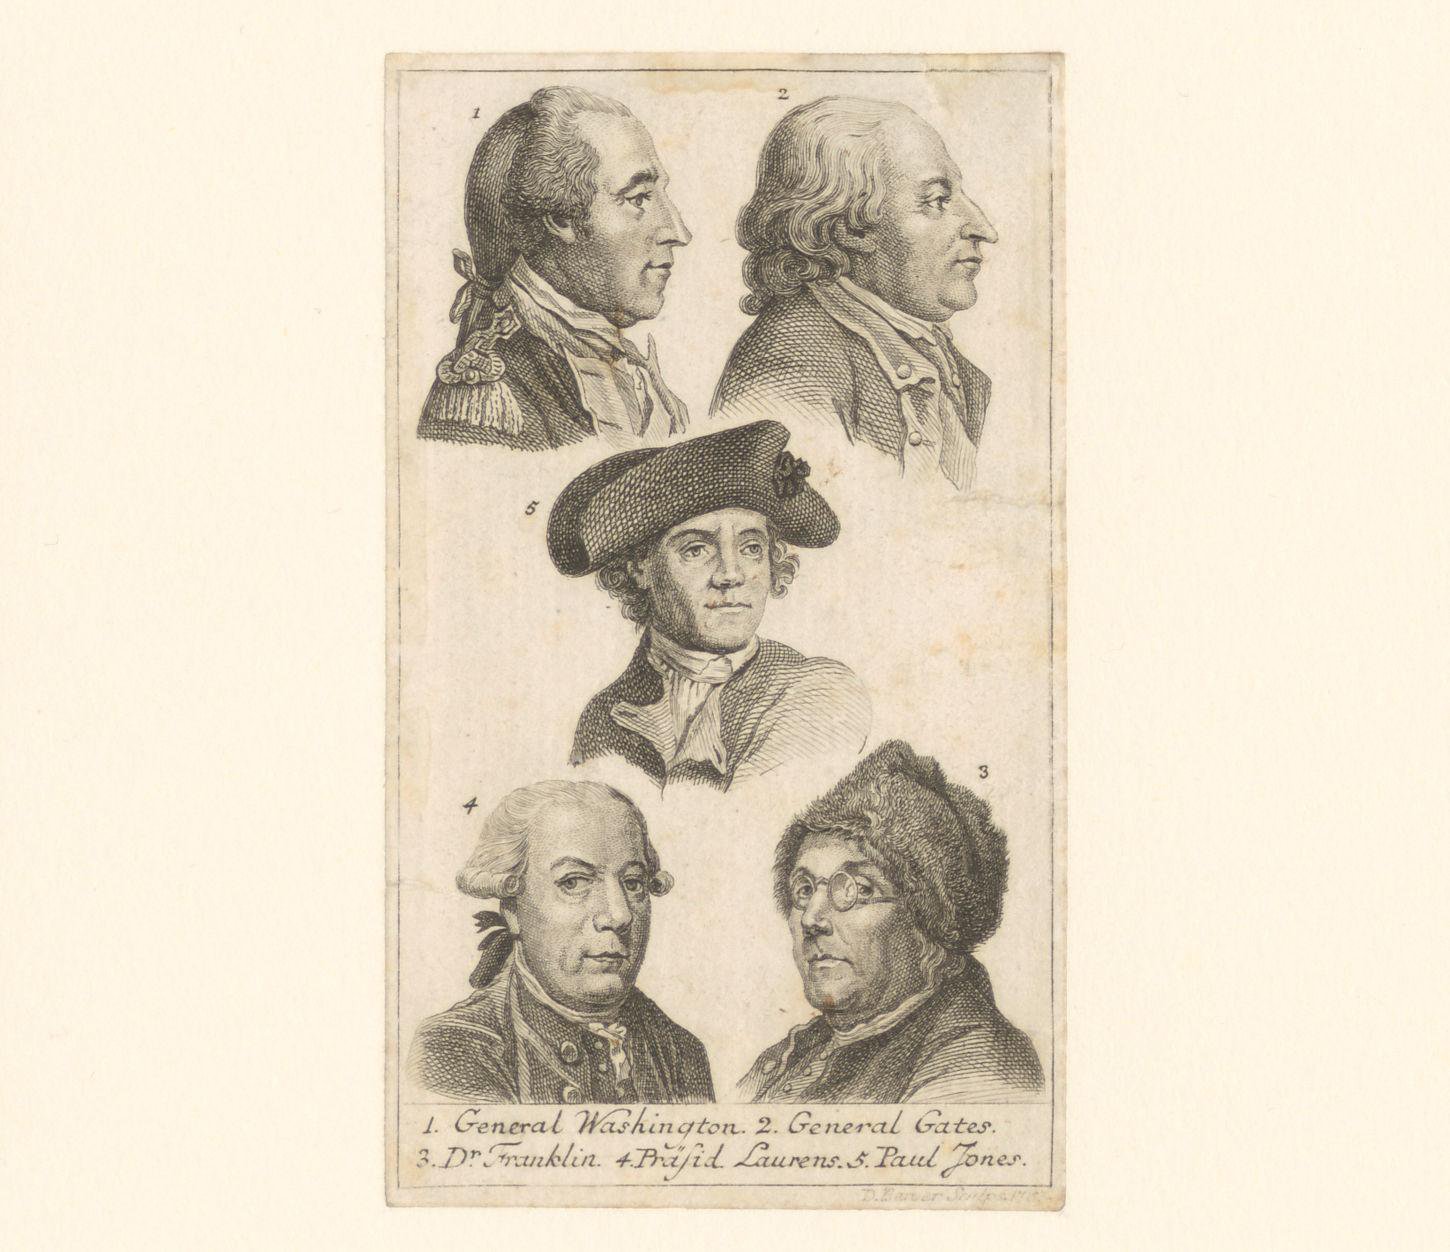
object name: book illustration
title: Portretten van George Washington, Horatio Gates, Benjamin Franklin, Henry Laurens en John Paul Jones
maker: daniel berger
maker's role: print maker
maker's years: 1744-1824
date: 1783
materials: paper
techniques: etching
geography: berlin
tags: capuche, new york (city), historical persons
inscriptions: collector's mark: Lugt 2228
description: Prent afkomstig uit: Sprengel, Matthias Christian. Allgemeines historisches Taschenbuch, oder Abriss der merkwürdigsten neuen Welt-Begebenheiten: enthaltend für 1784 die Geschichte der Revolution von Nord-America. Berlijn: Haude & Spener, [1783].